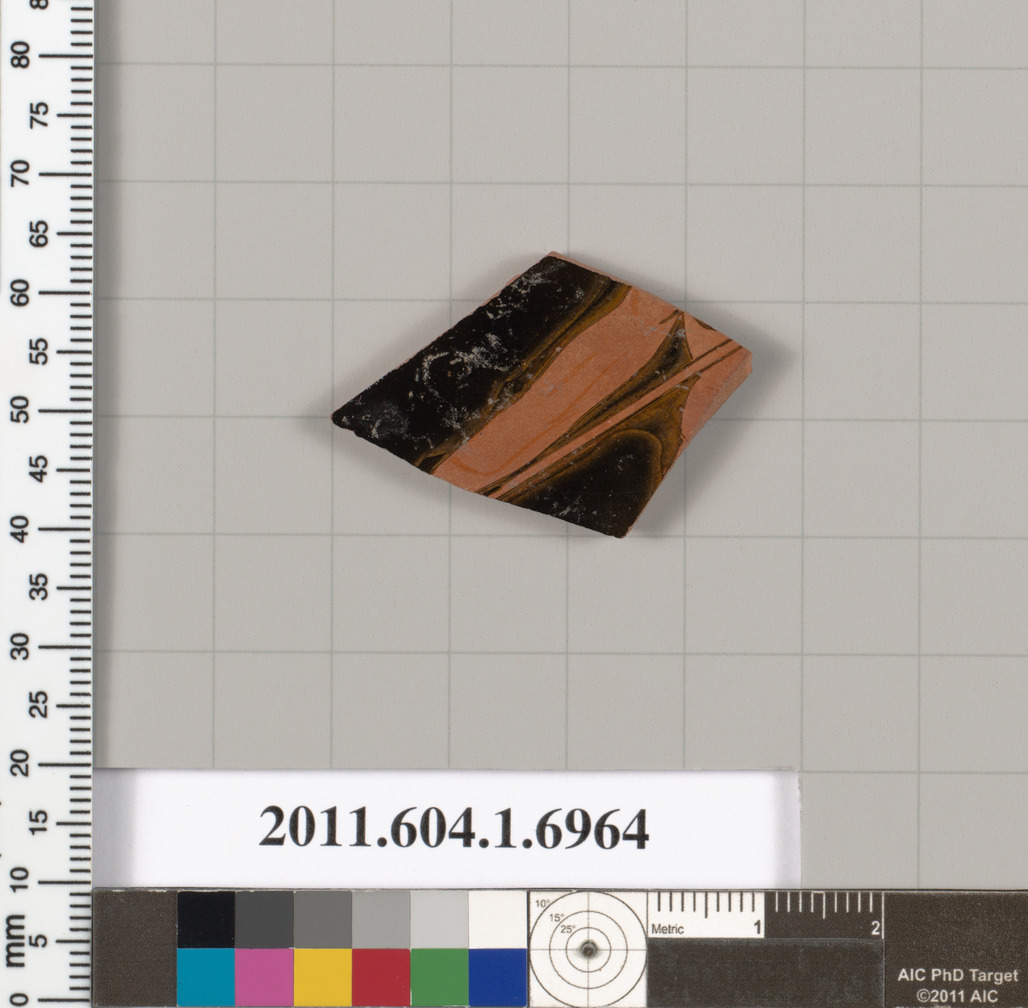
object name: kylix fragment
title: Terracotta fragment of a kylix (drinking cup)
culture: greek, attic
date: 490-470 BCE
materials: terracotta